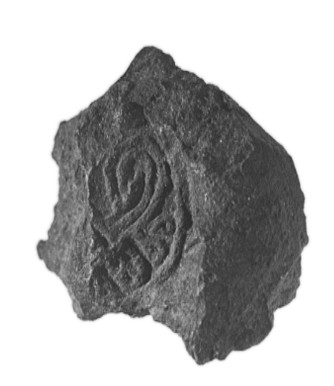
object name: sealing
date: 2030-1640 BCE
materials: clay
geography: egypt